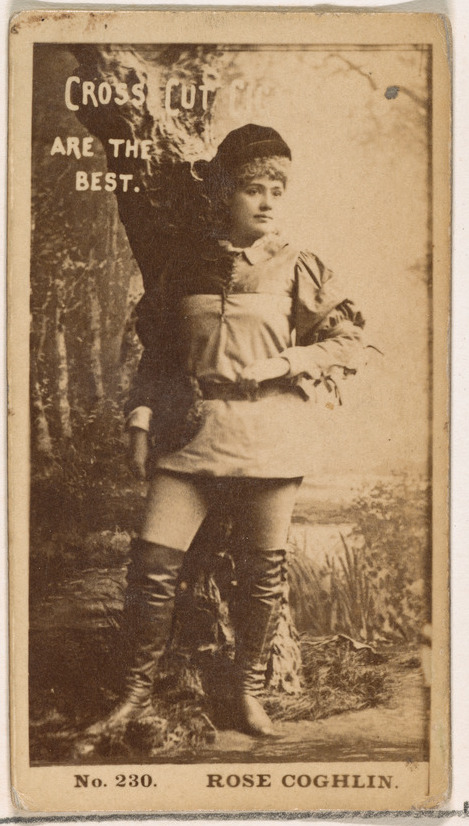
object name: print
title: Card Number 230, Rose Coghlin, from the Actors and Actresses series (N145-2) issued by Duke Sons & Co. to promote Cross Cut Cigarettes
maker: w. duke, sons & co.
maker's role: publisher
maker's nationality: american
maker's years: 1870-1920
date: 1880-1889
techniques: albumen silver print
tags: portraits,women,actresses